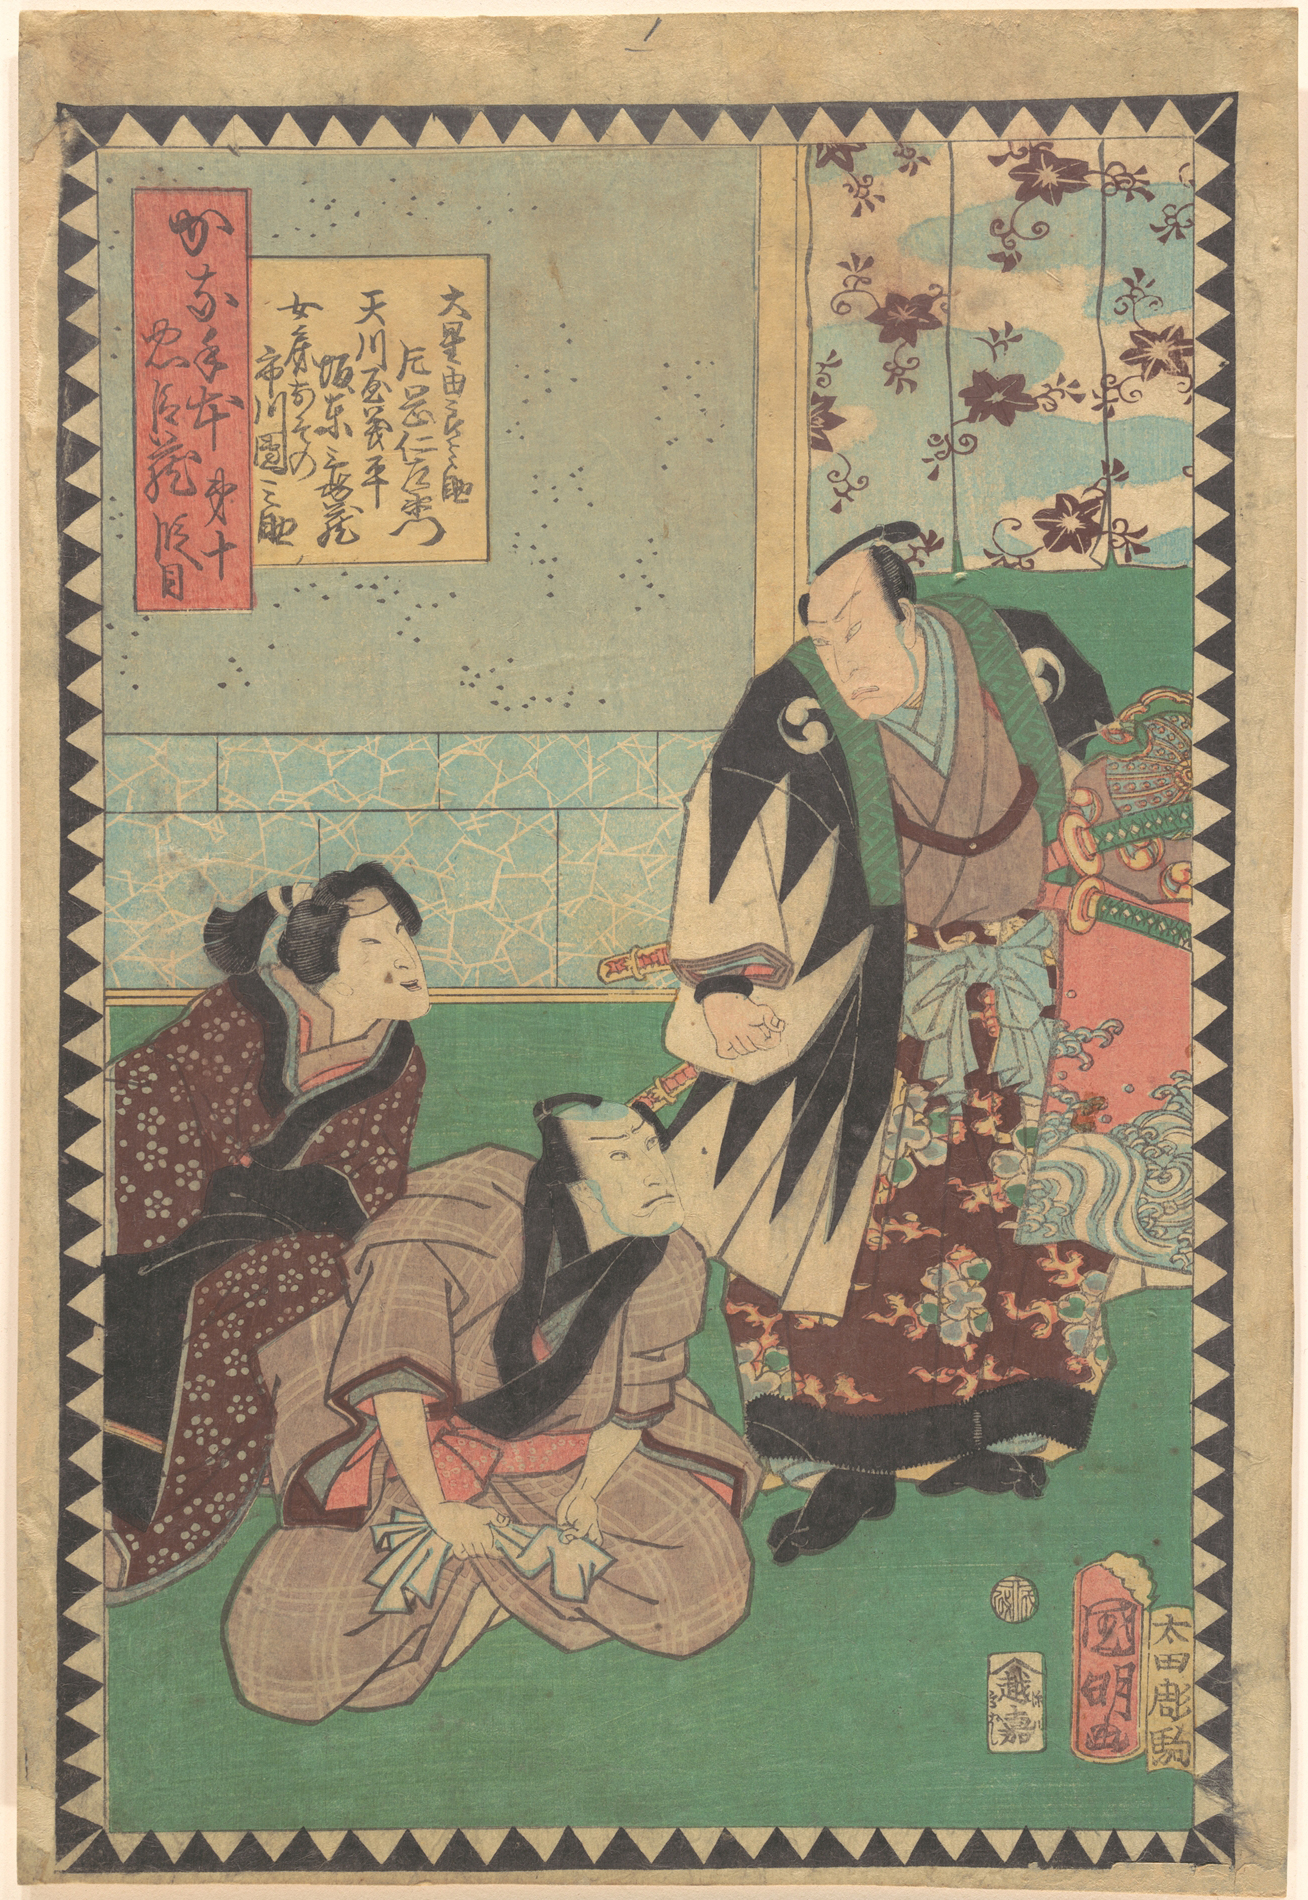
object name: print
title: Act X (Dai jūdanme): Actors Kataoka Nizaemon VIII as Ōboshi Yuranosuke, Bandō Kamezō I as Amakawaya Gihei, and Ichikawa Dannosuke V as His Wife (Nyōbō) Osono, from the series The Storehouse of Loyal Retainers, a Primer (Kanadehon chūshingura)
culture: japanese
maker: utagawa kuniaki ii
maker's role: artist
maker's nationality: japanese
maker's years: 1835-1888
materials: ink, paper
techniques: woodblock print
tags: men,portraits,actors